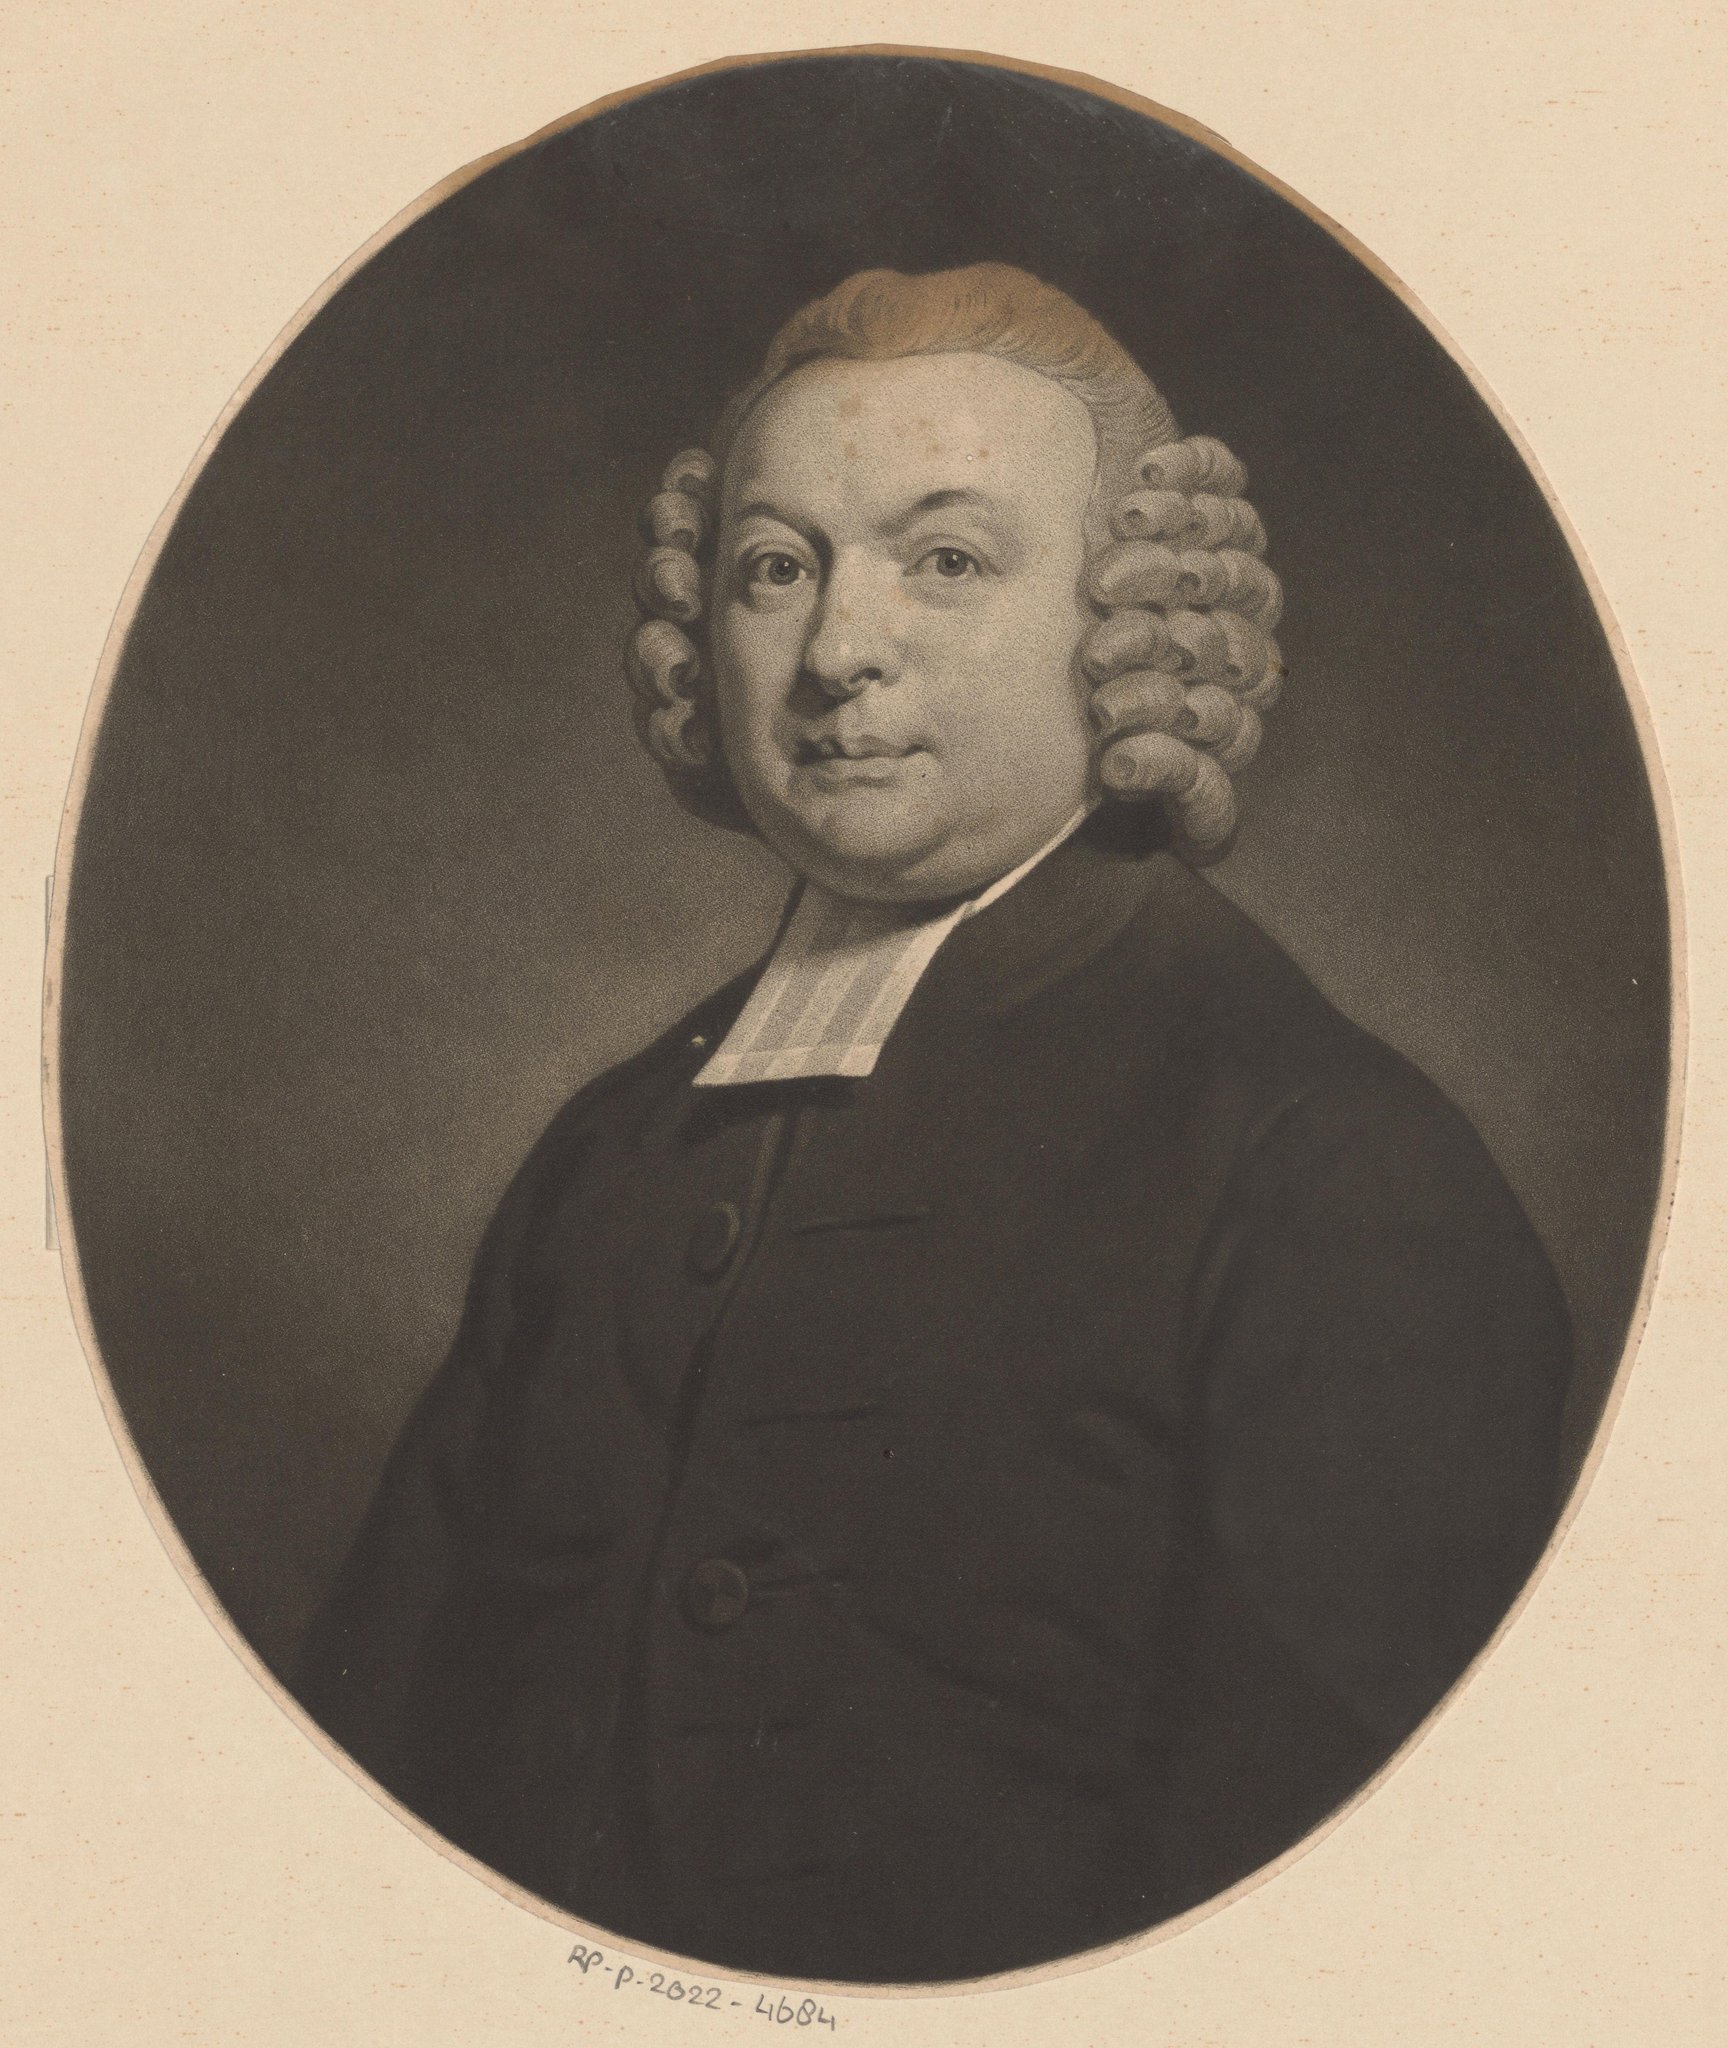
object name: print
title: Portret van Johannes Visch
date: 1804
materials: paper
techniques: mezzotint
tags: utrecht, theologian, historical persons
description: Prent is mogelijk afkomstig uit groter geheel, zie RP-P-1906-3417.